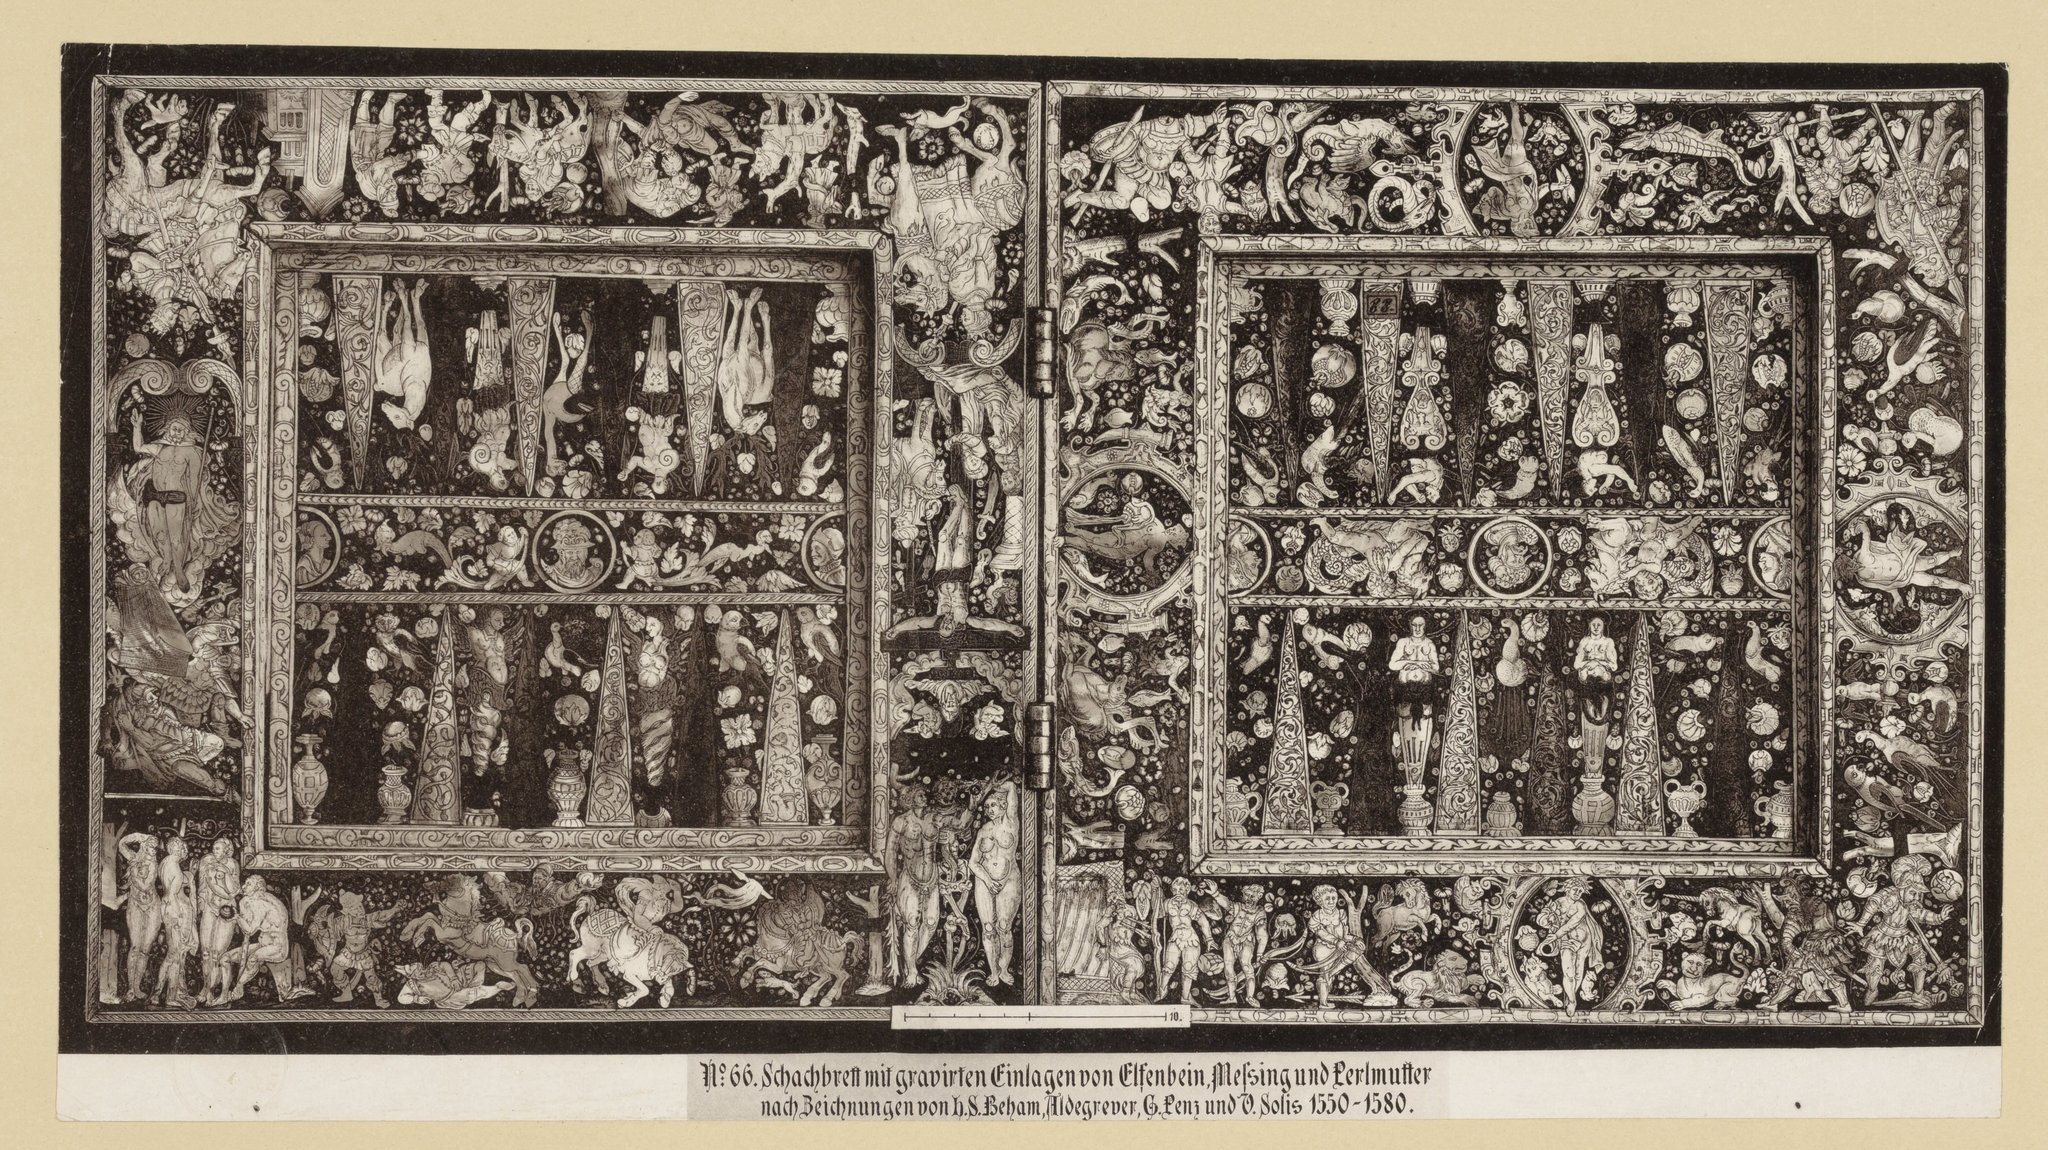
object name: photomechanical print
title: Schaakbord met inleg van ivoor, messing en parelmoer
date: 1869-1887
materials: cardboard, paper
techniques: photograph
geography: munich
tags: chess, work of applied art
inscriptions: number: ‘No. 66.’, check stamp: ‘Bayerisches National-Museum’, inscription: ‘Barmhartige Samaritaan’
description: De ingelegde voorstelling is gemaakt naar prenten van Beham, Aldegrever, Pencz en Solis.